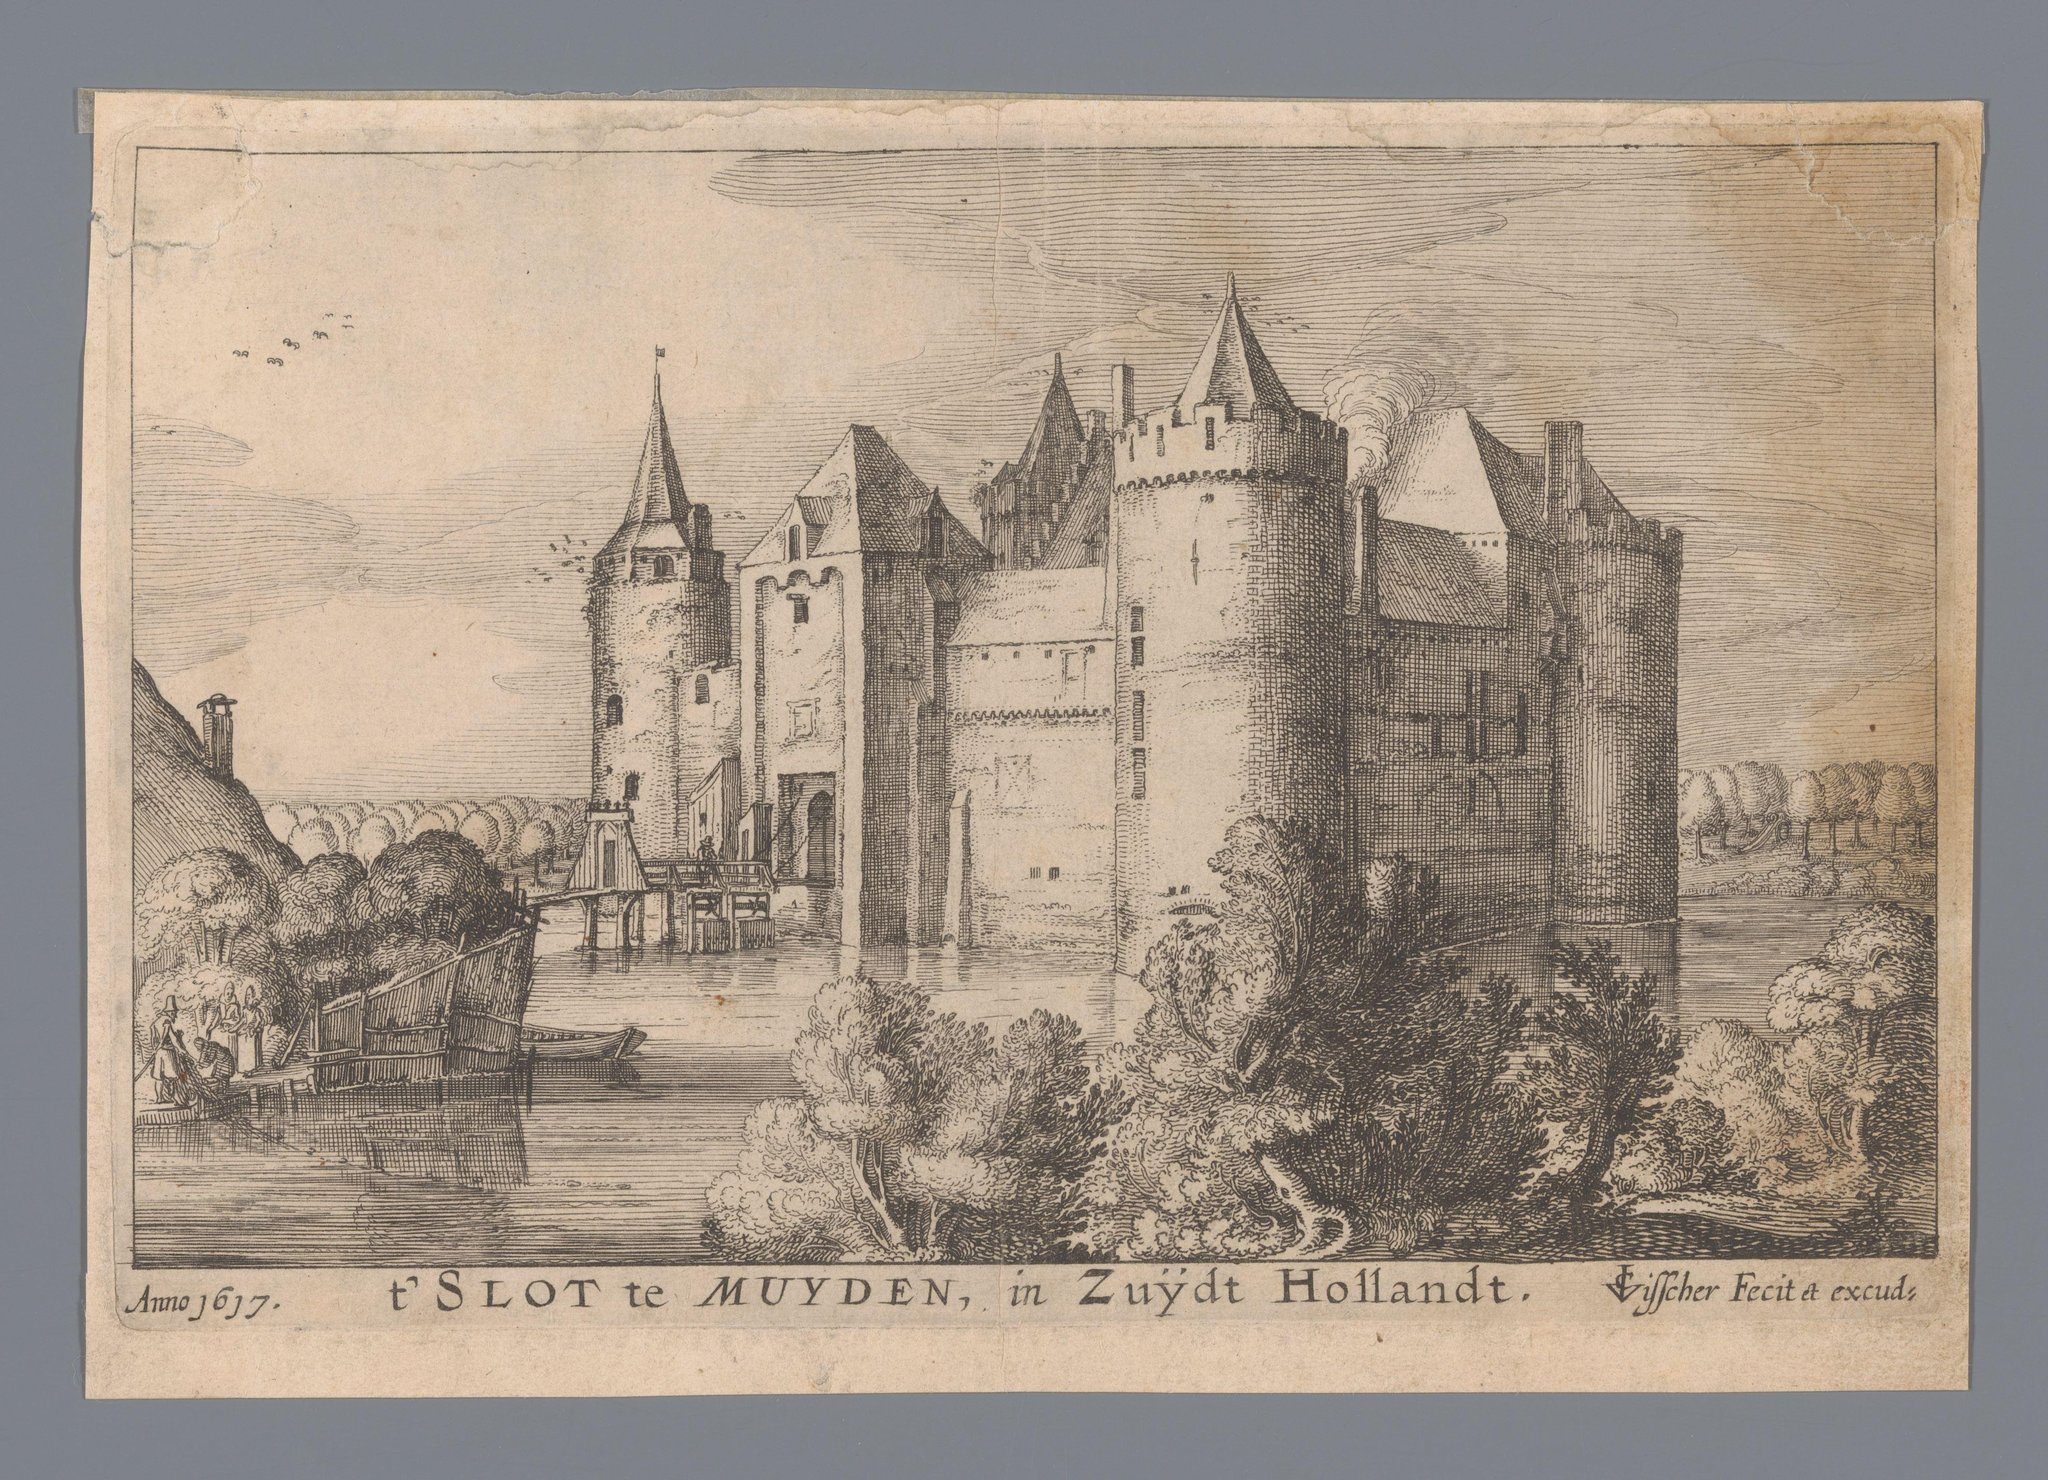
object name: print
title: 't Slot te Muyden, in Zuijdt Hollandt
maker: claes jansz. visscher (ii)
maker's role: draughtsman, print maker, publisher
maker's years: 1586-1652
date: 1617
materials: paper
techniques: etching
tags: castle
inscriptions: date